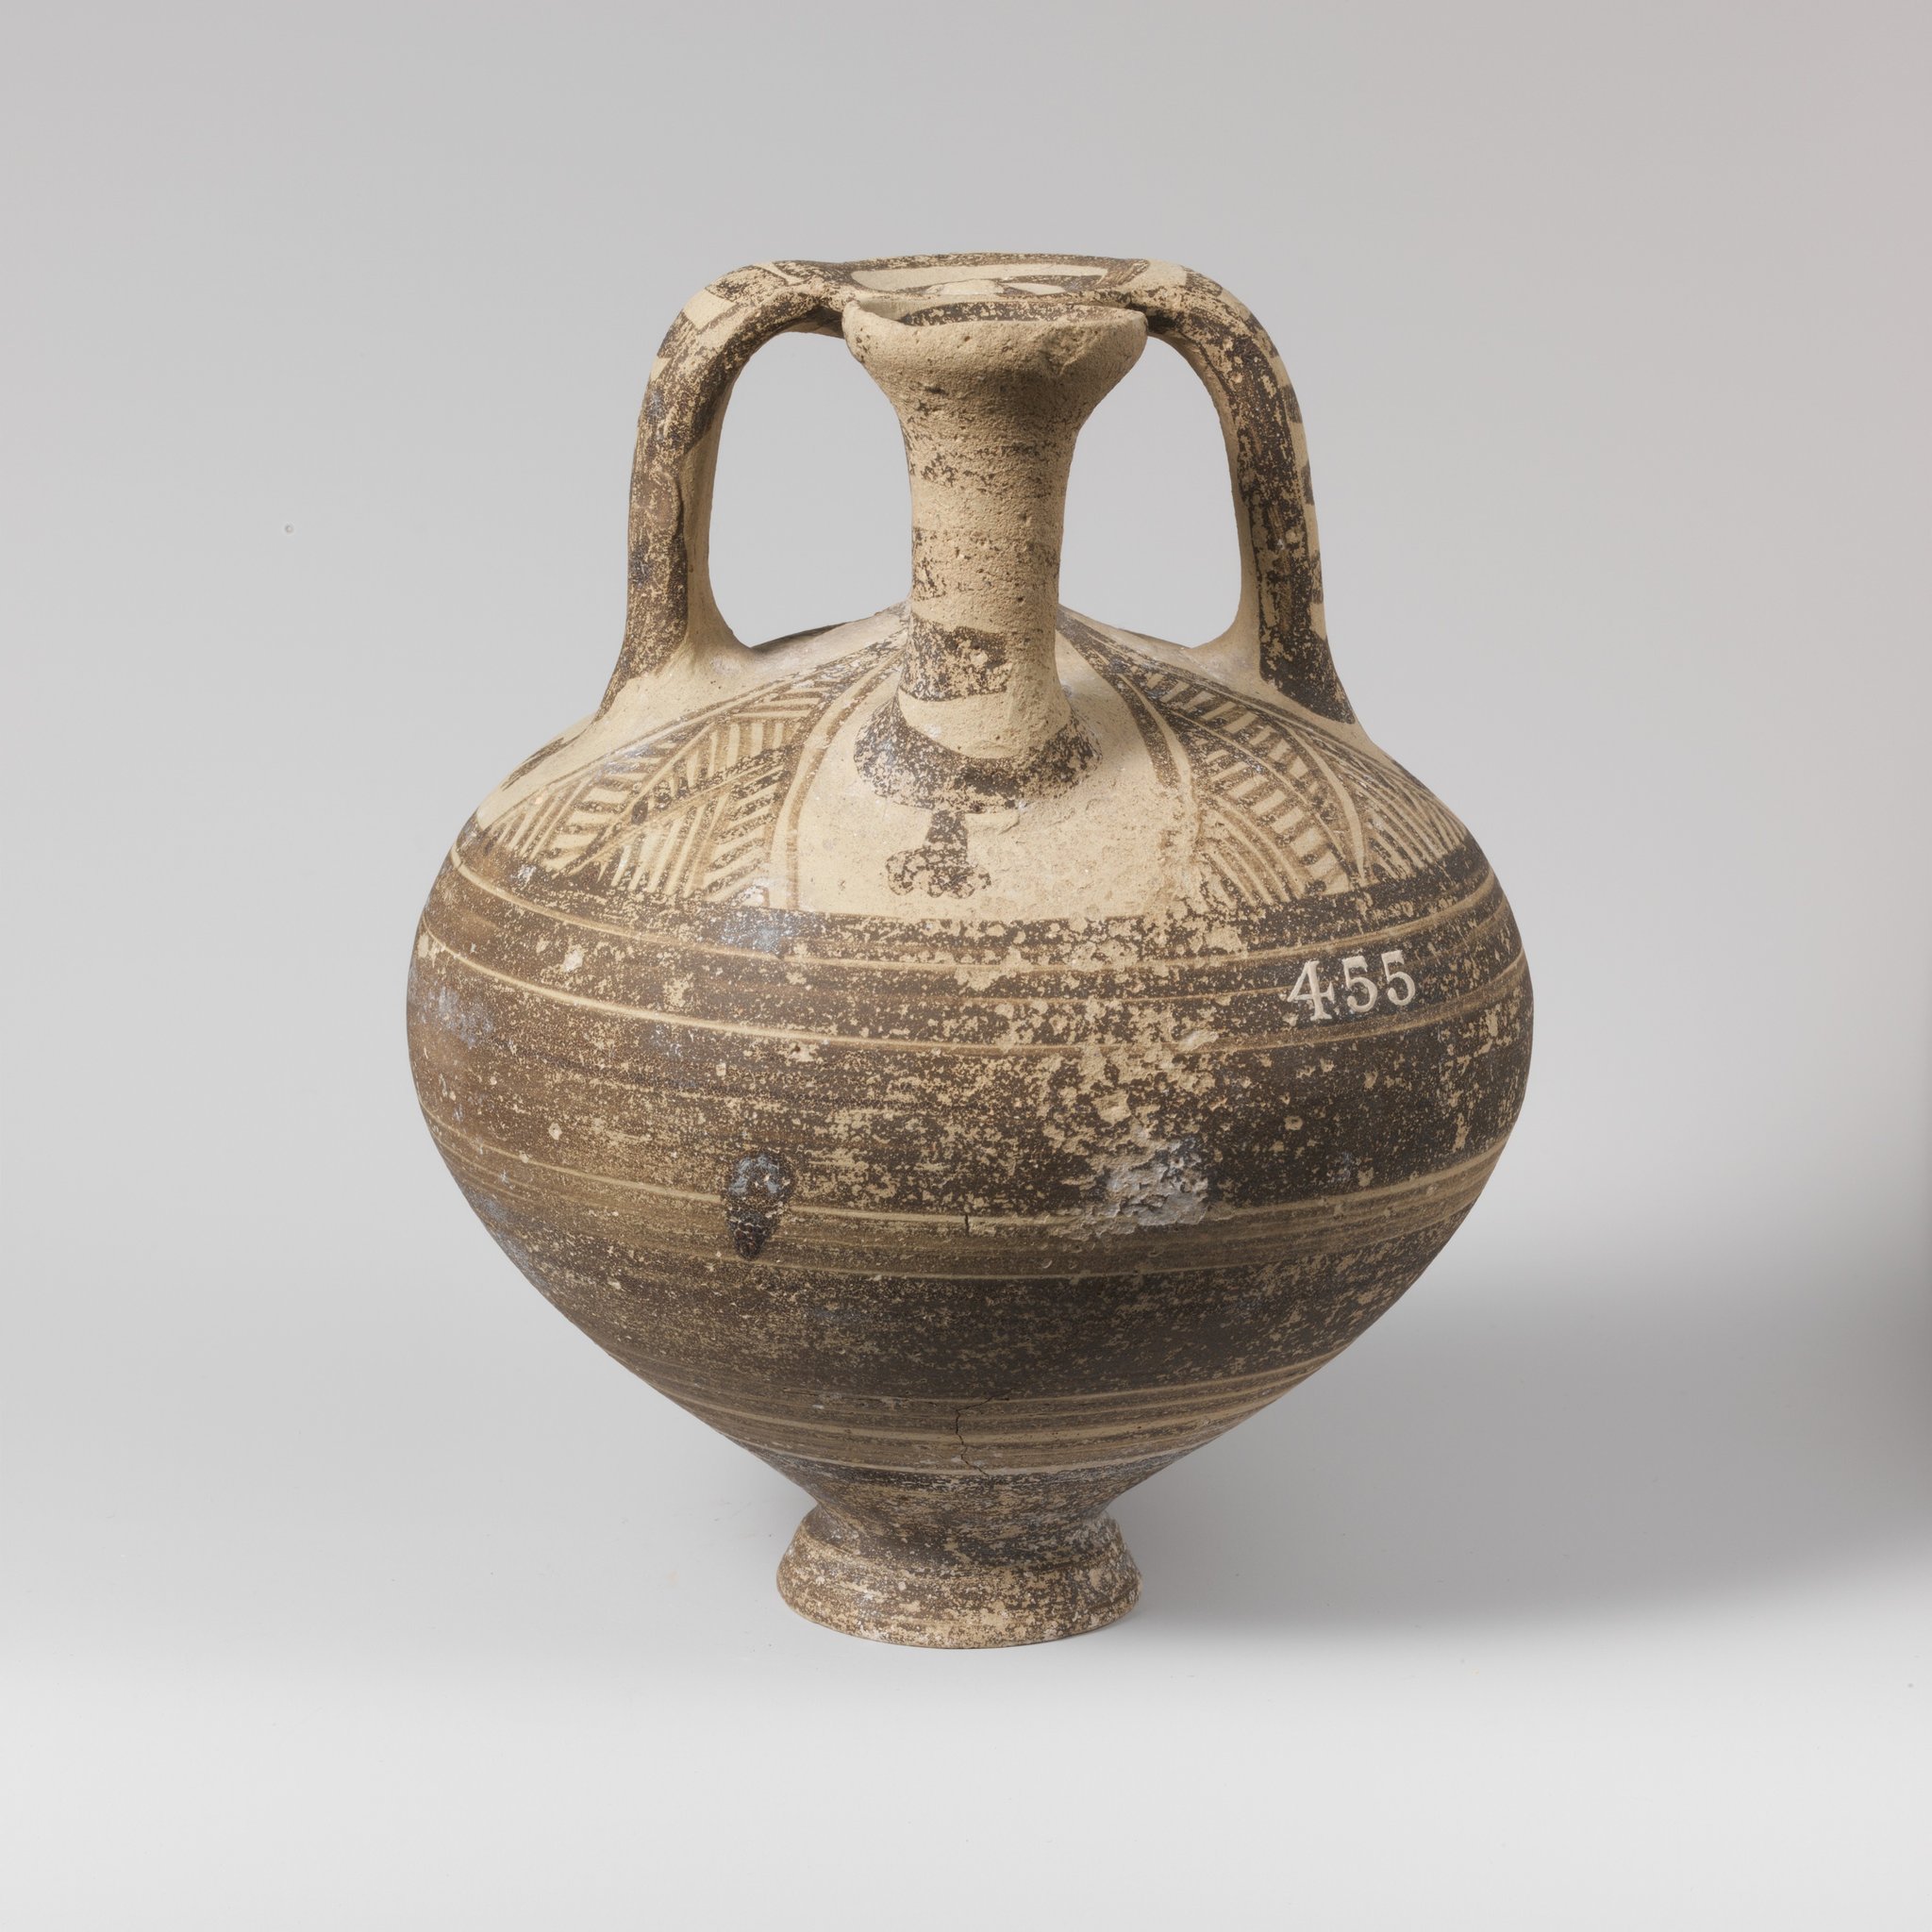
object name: stirrup jar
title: Terracotta stirrup jar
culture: cypriot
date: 1100-1068 BCE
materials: terracotta